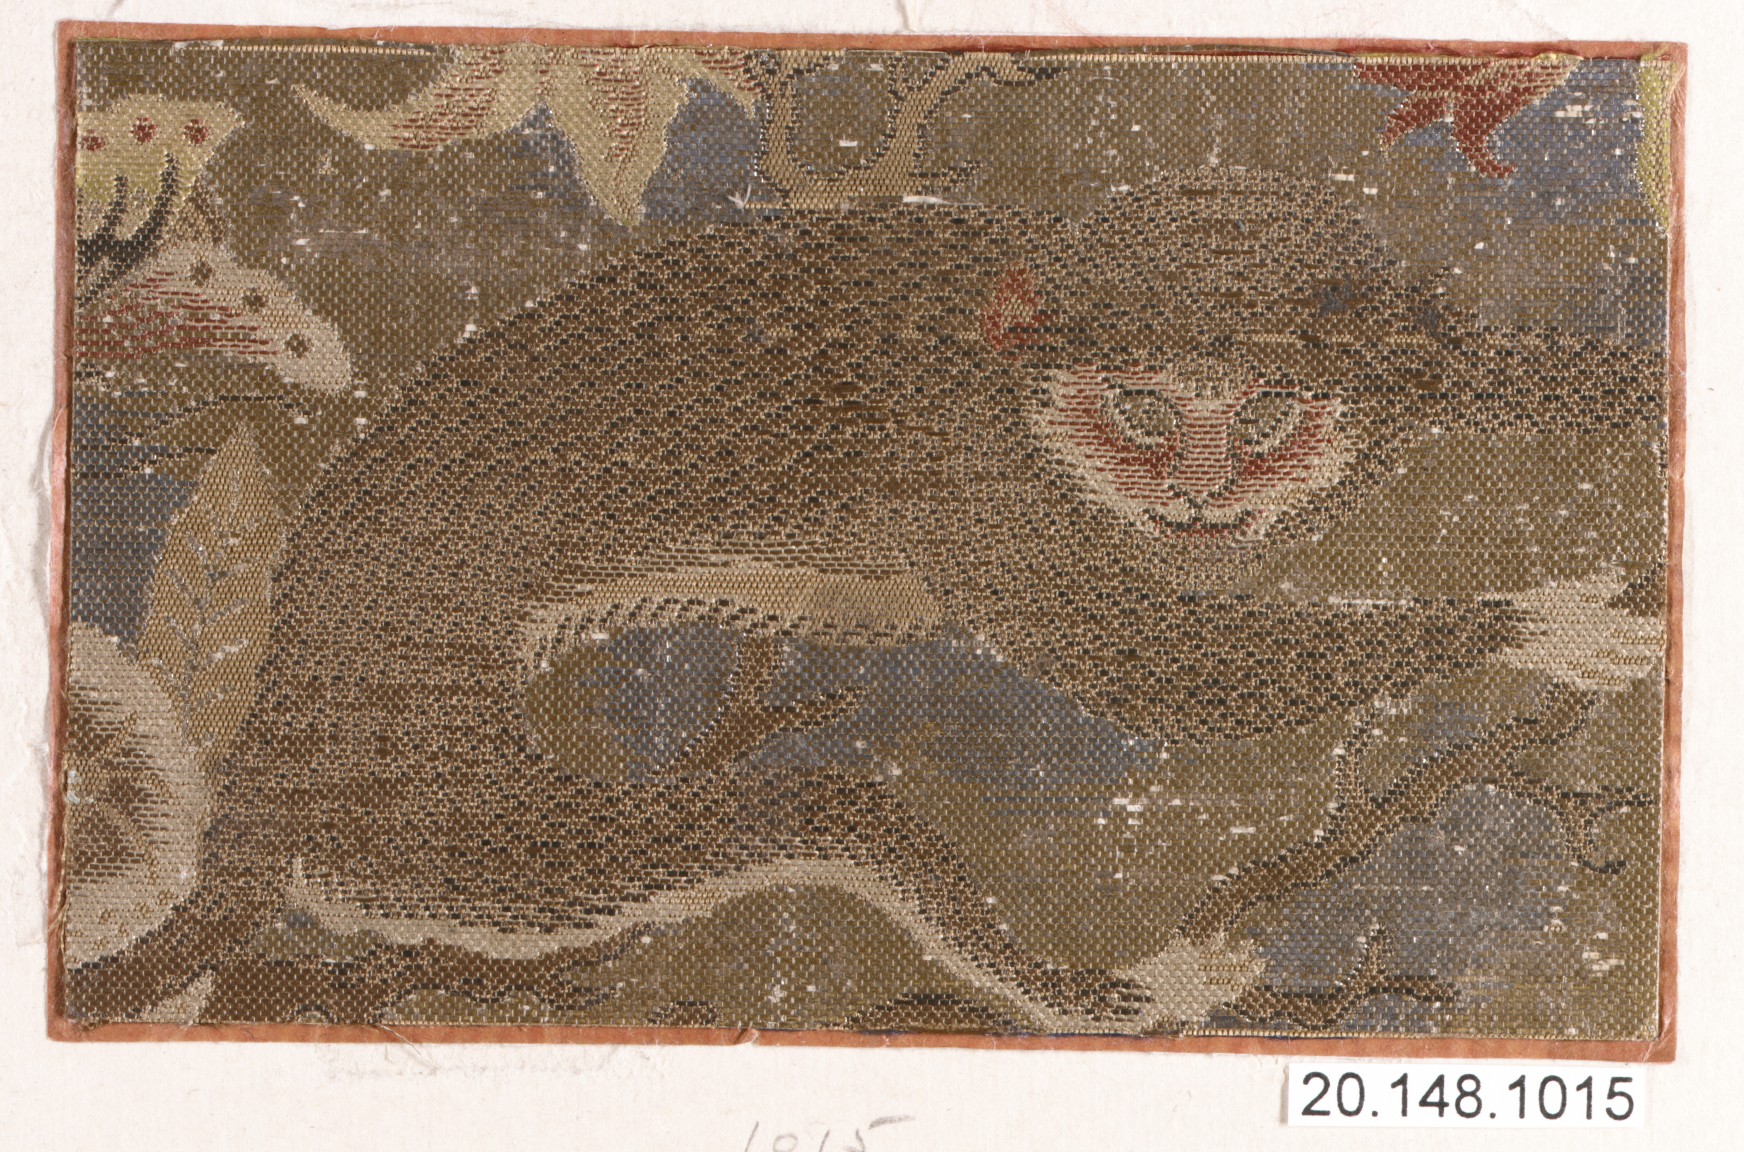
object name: piece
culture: japanese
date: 1701-1800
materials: silk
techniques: compound weave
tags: monkeys